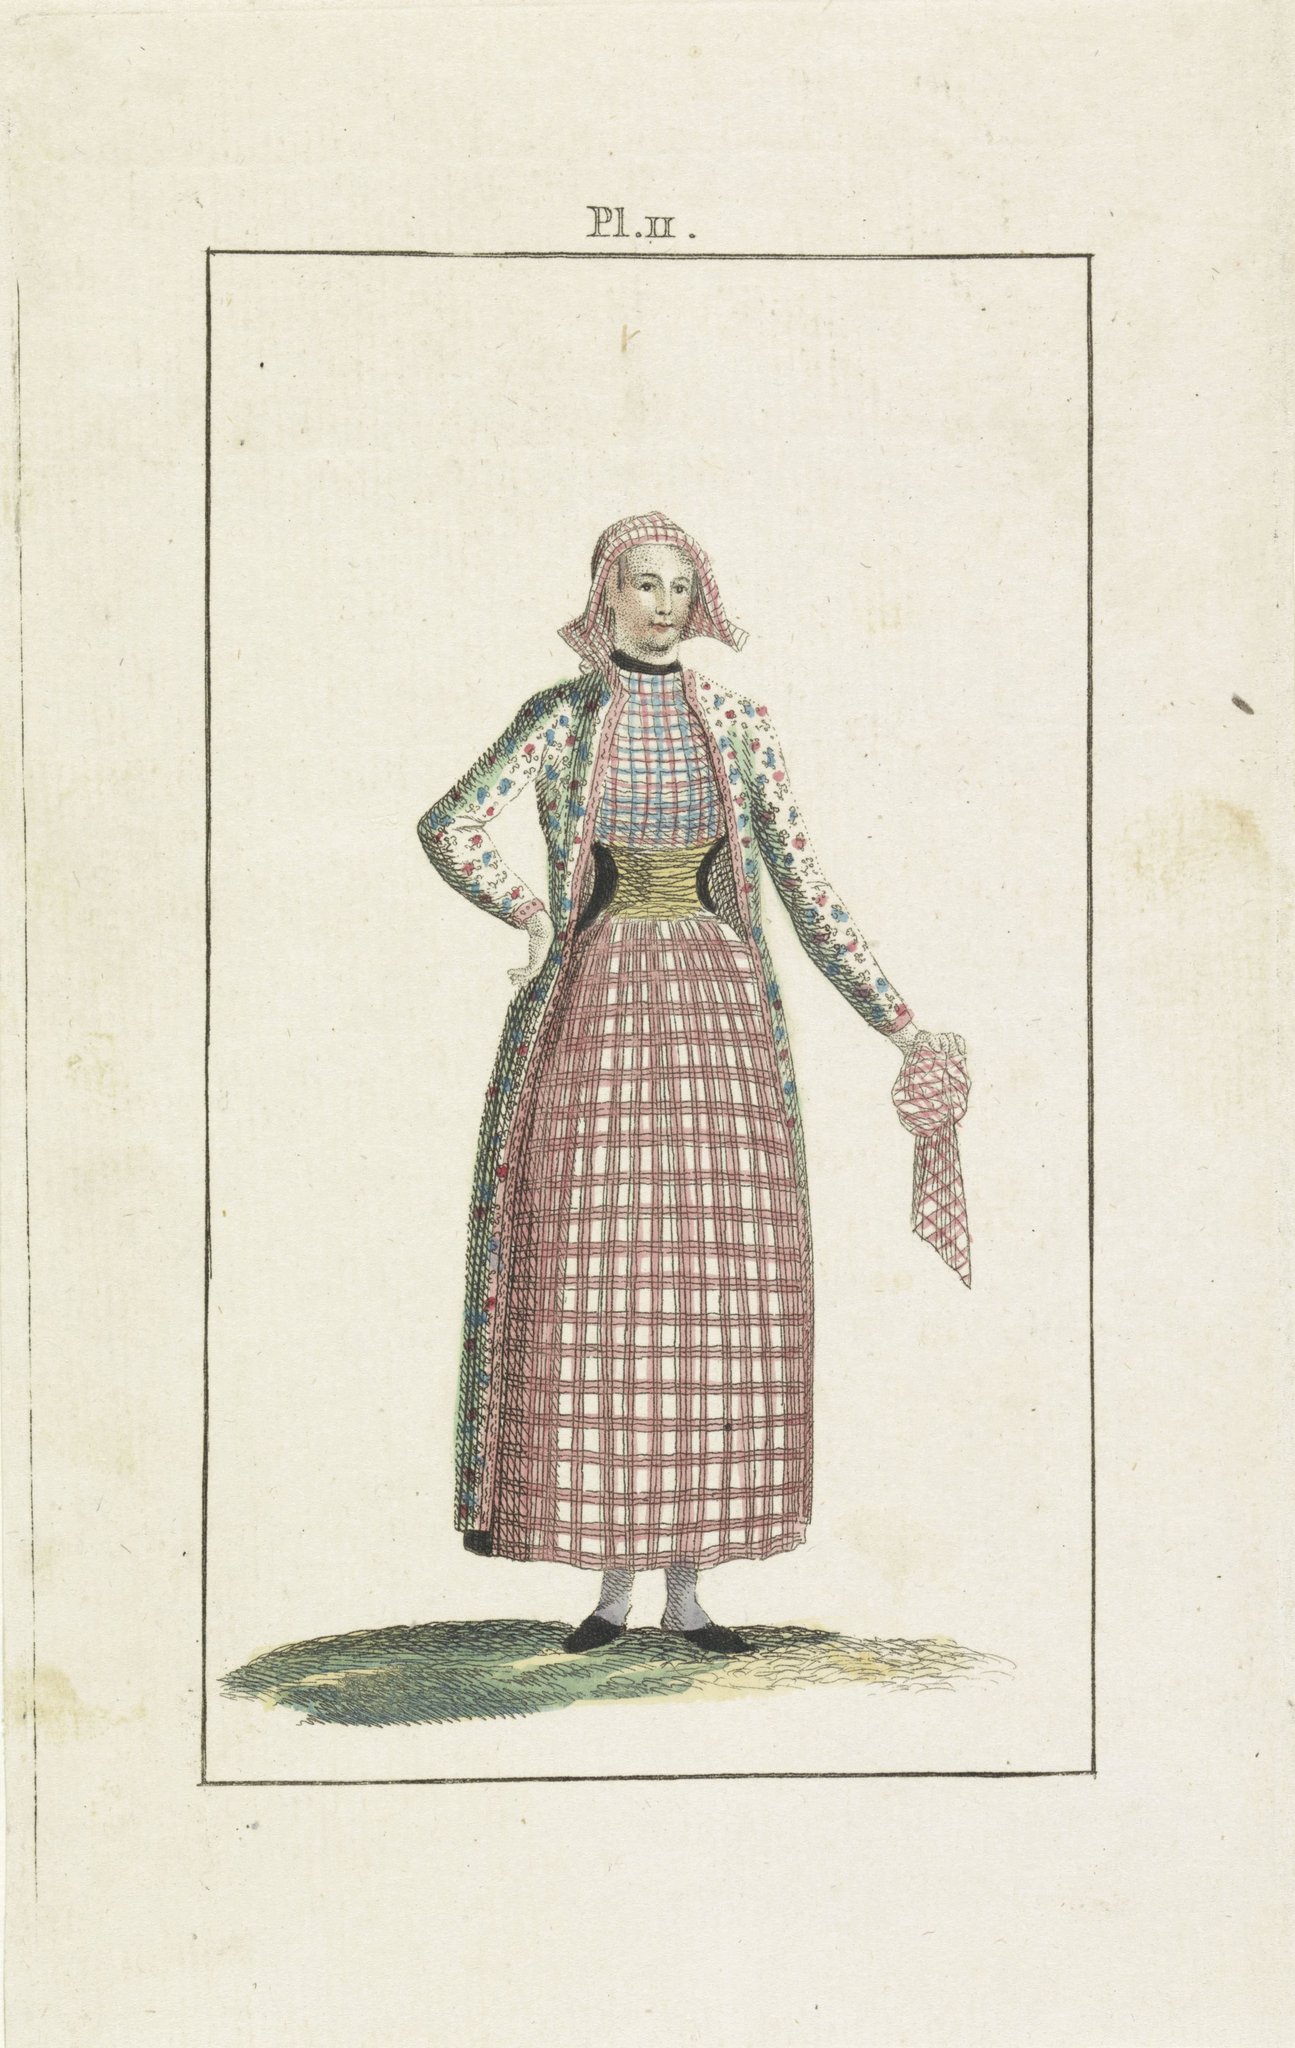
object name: print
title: Klederdracht vrouw van Hindeloopen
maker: Anonymous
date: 1790-1792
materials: paper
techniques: etching, hand coloring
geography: netherlands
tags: folk costume, regional costume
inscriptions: collector's mark: Lugt 2228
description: Klederdracht van een vrouw uit Hindeloopen. Plaat II in een reeks van vier illustraties van klederdrachten in Nederland in 1792.